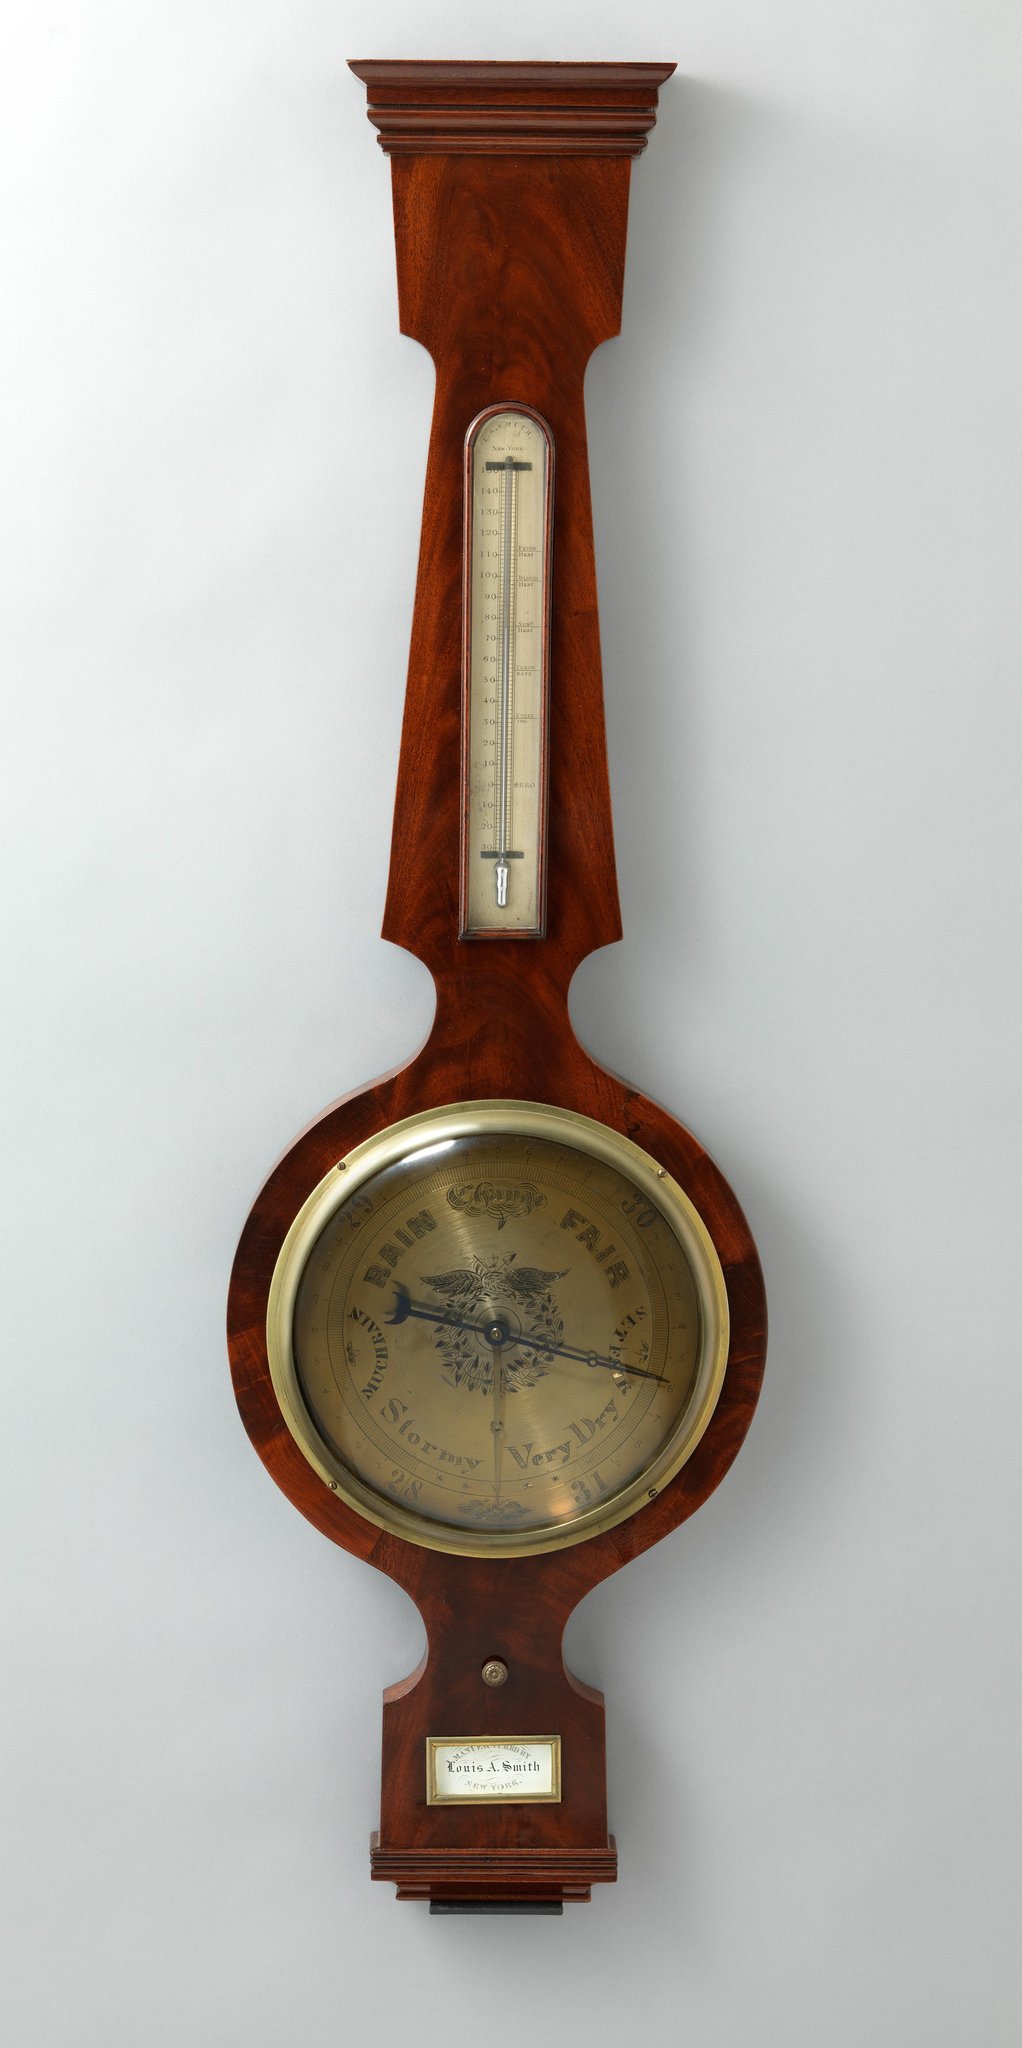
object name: wheel barometer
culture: american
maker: louis a. smith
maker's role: maker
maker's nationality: american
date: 1841-1845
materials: brass, wood, paper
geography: united states